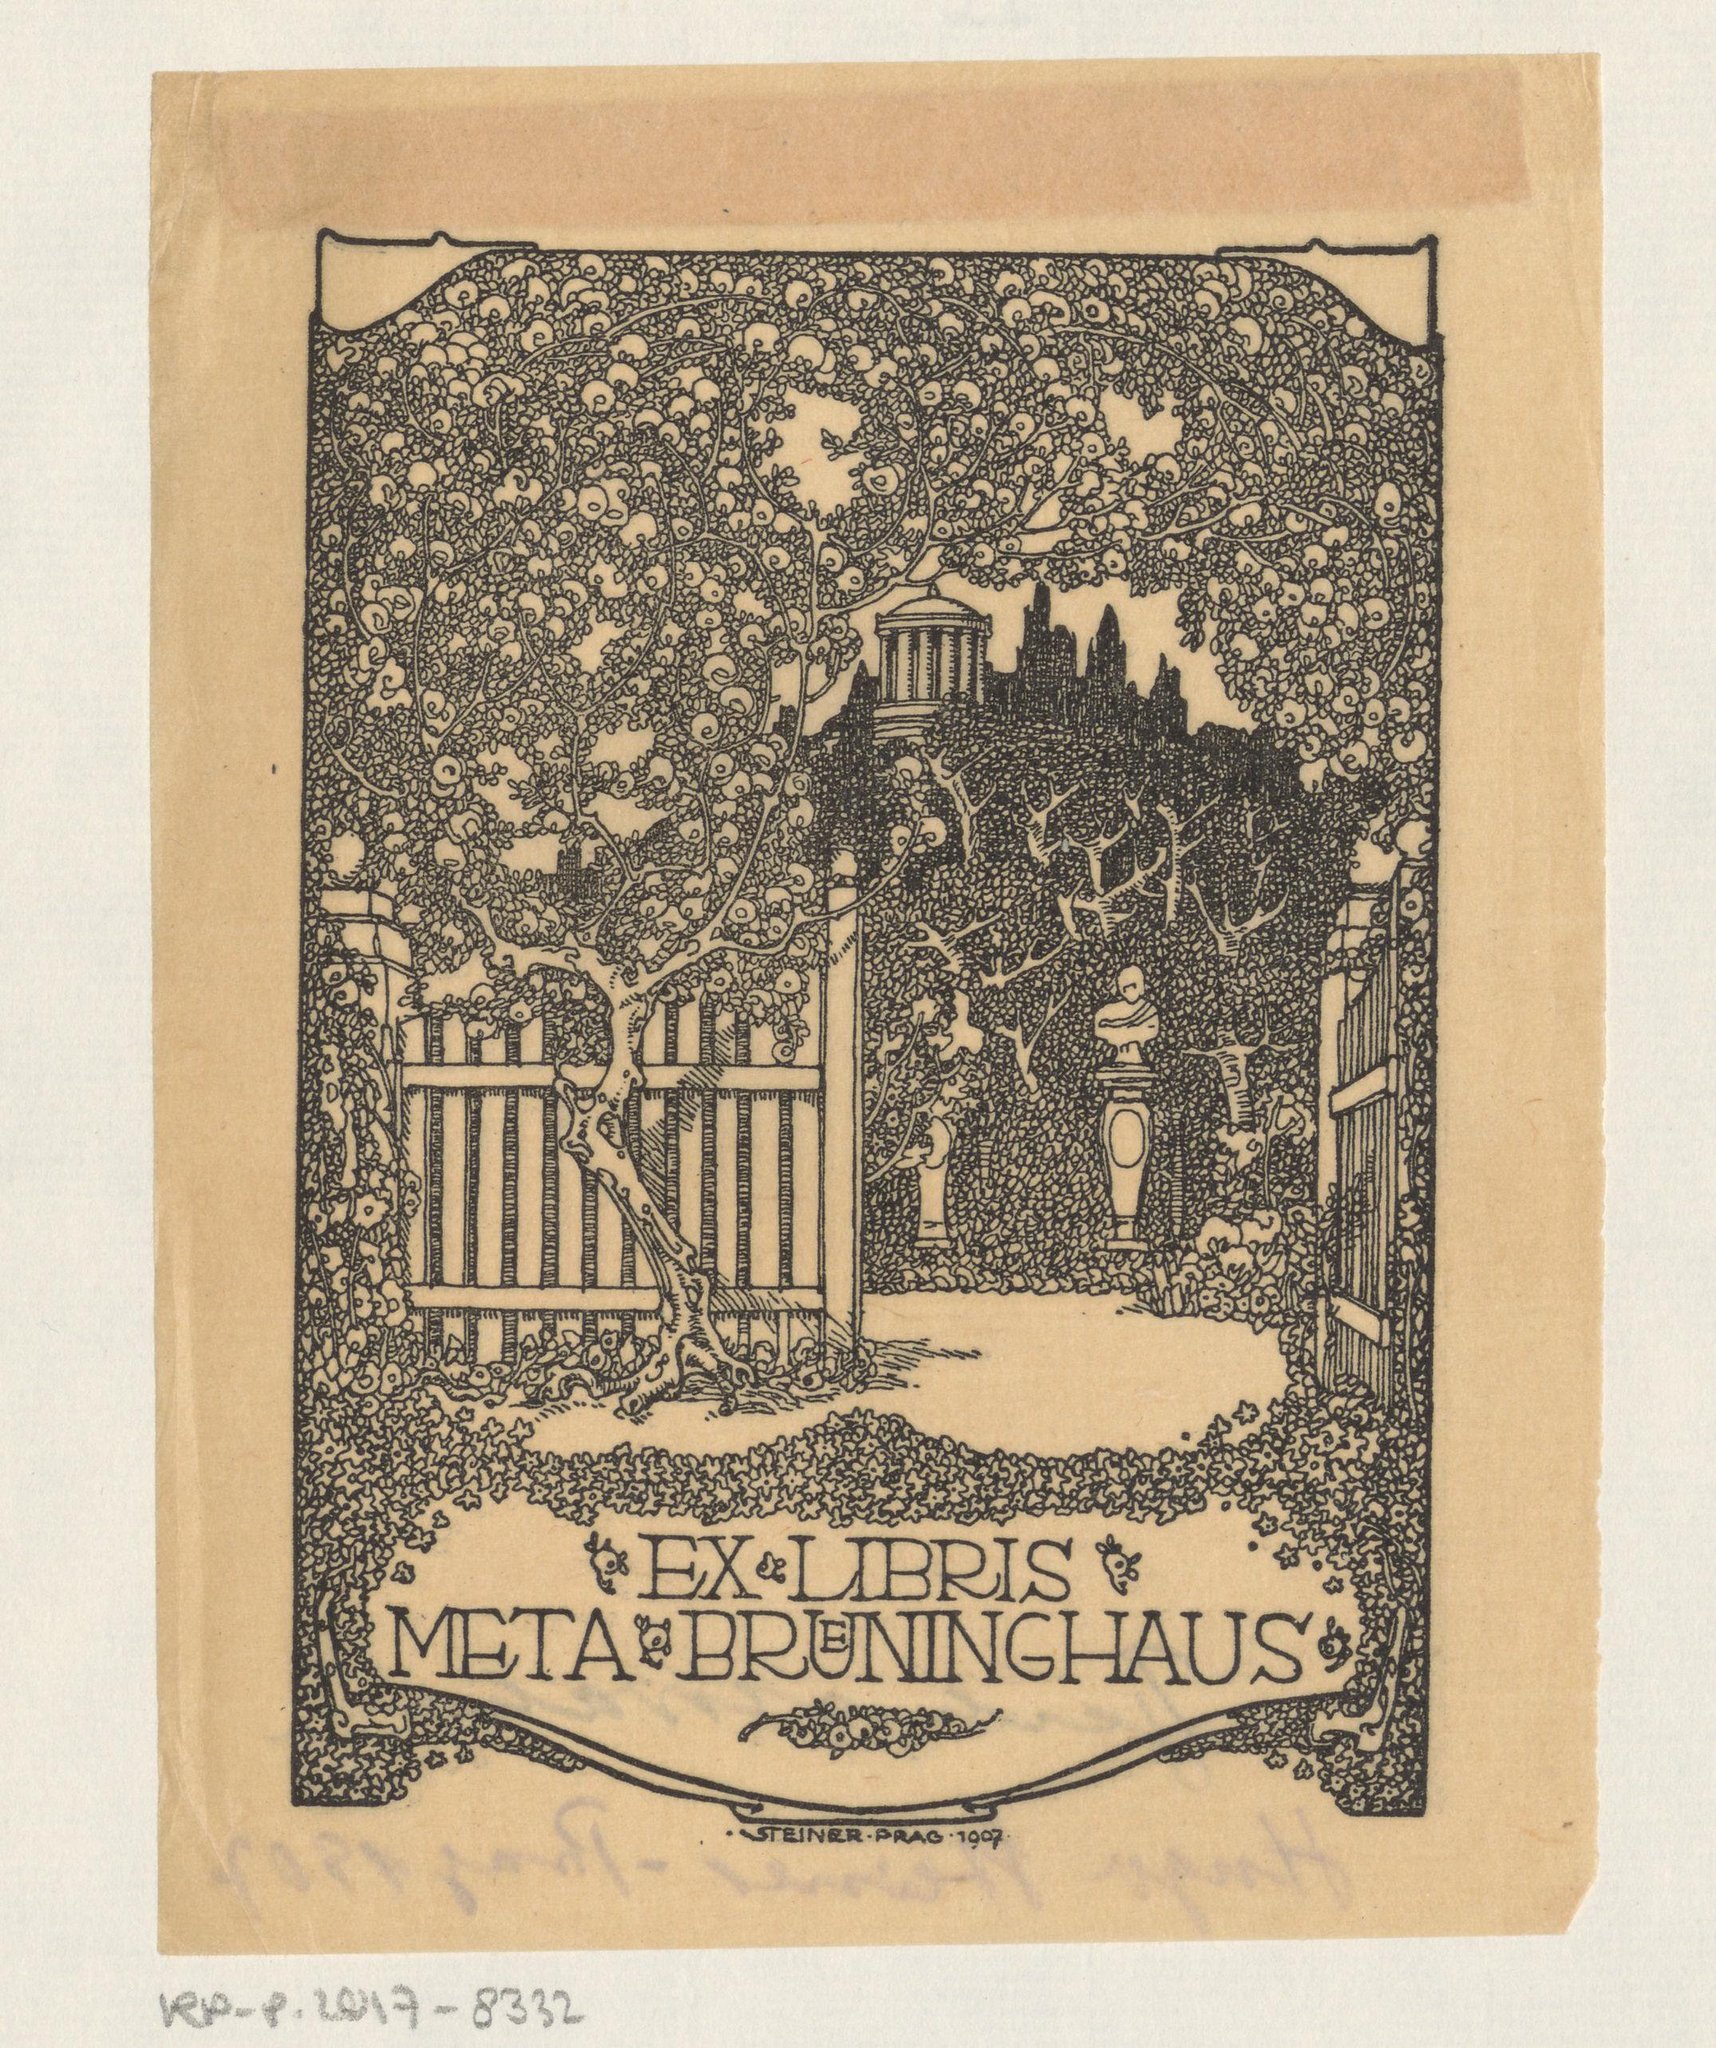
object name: bookplate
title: Ex libris van Meta Brueninghaus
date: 1907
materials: paper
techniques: printing block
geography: czech republic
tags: trees, garden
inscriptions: date